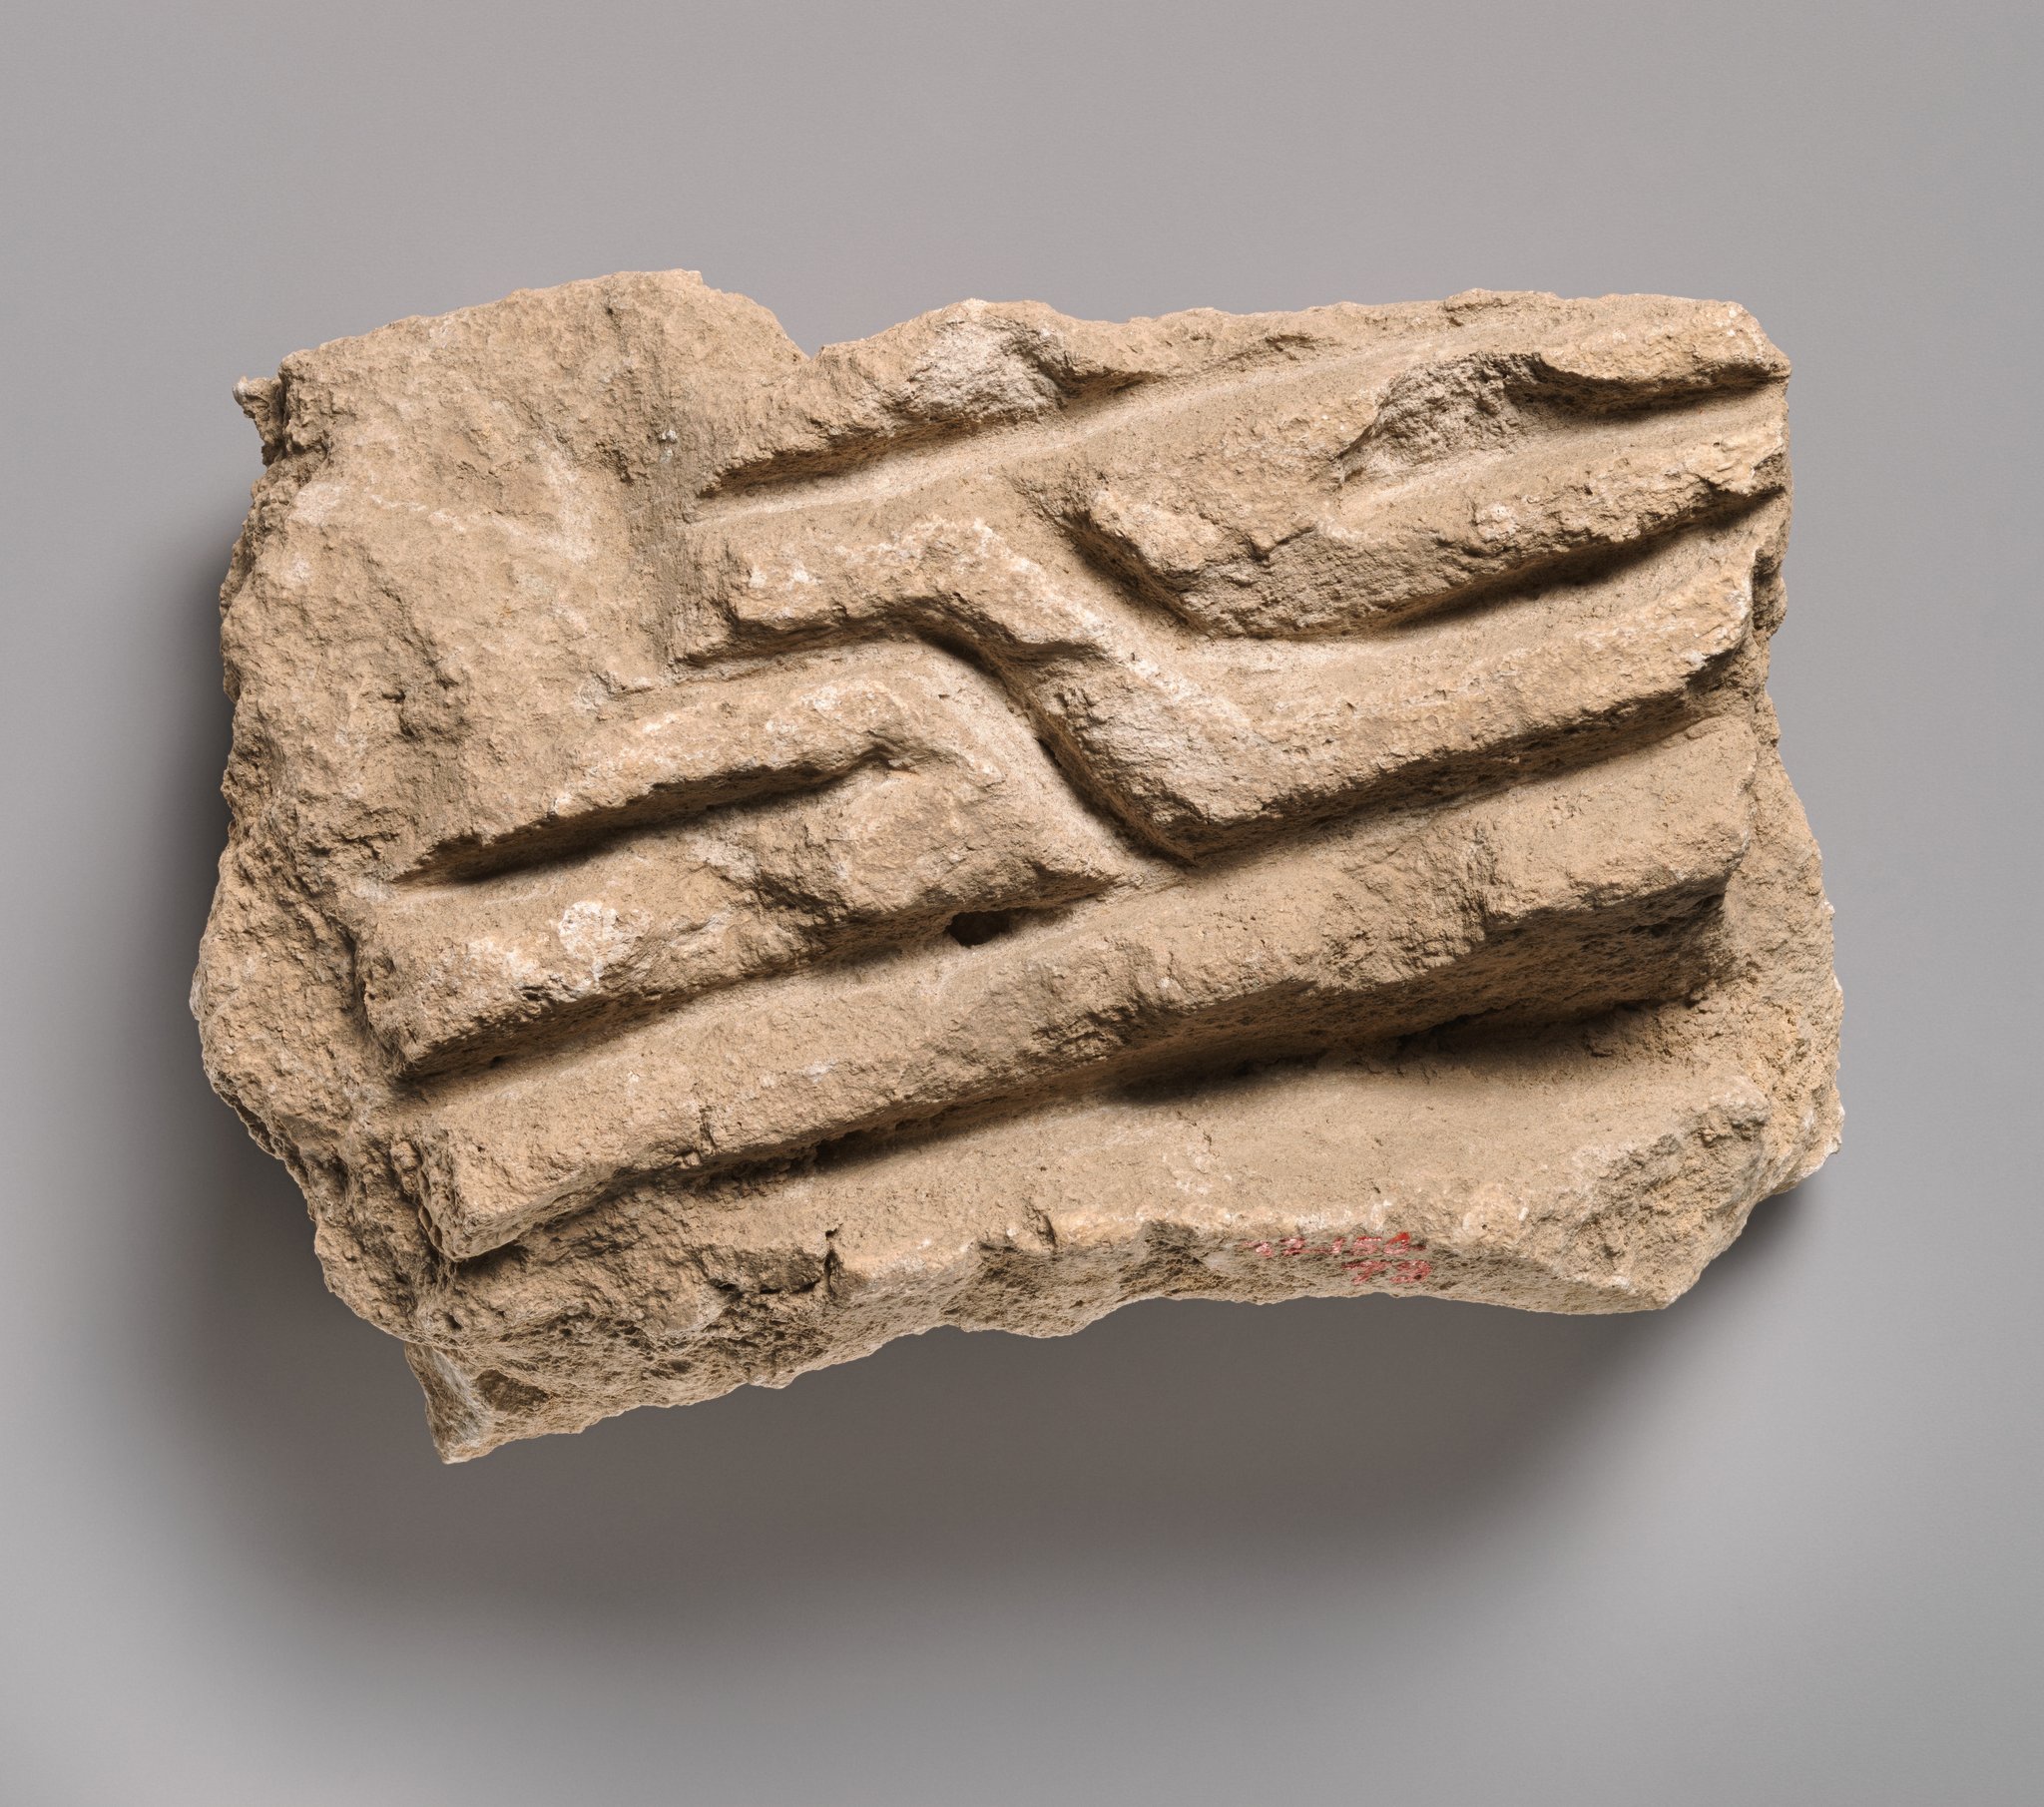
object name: relief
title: Relief fragment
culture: sasanian or islamic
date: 501-800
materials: plaster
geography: mesopotamia